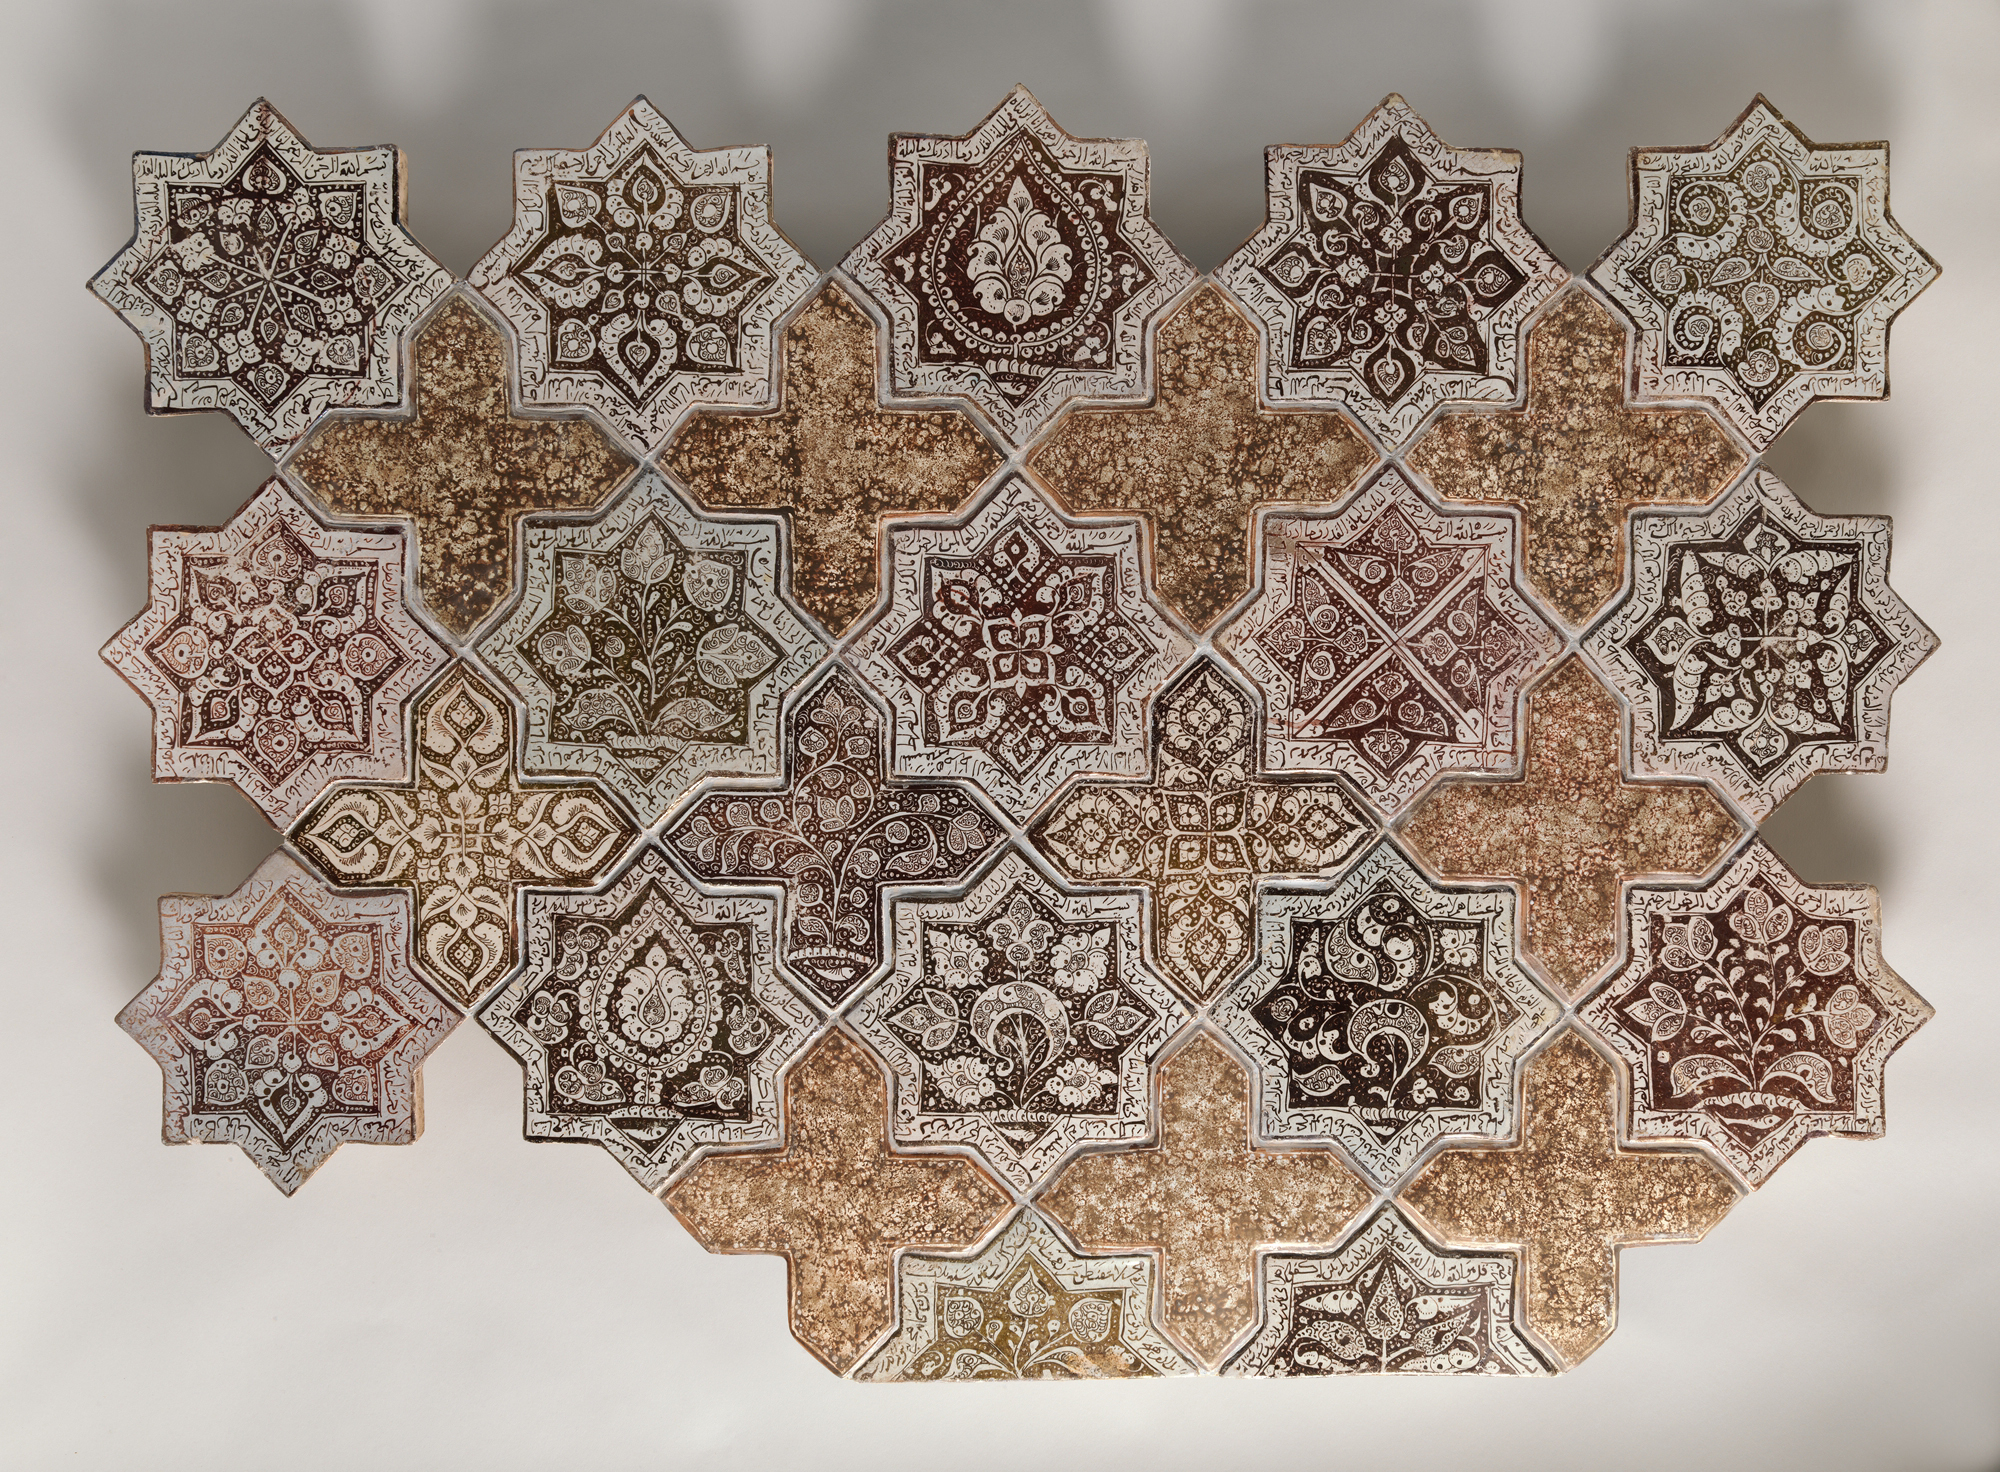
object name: tile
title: Panel Composed with Tiles in Shape of Eight-pointed Stars and Crosses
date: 1260-1270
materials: glaze, stonepaste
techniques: luster painting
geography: iran